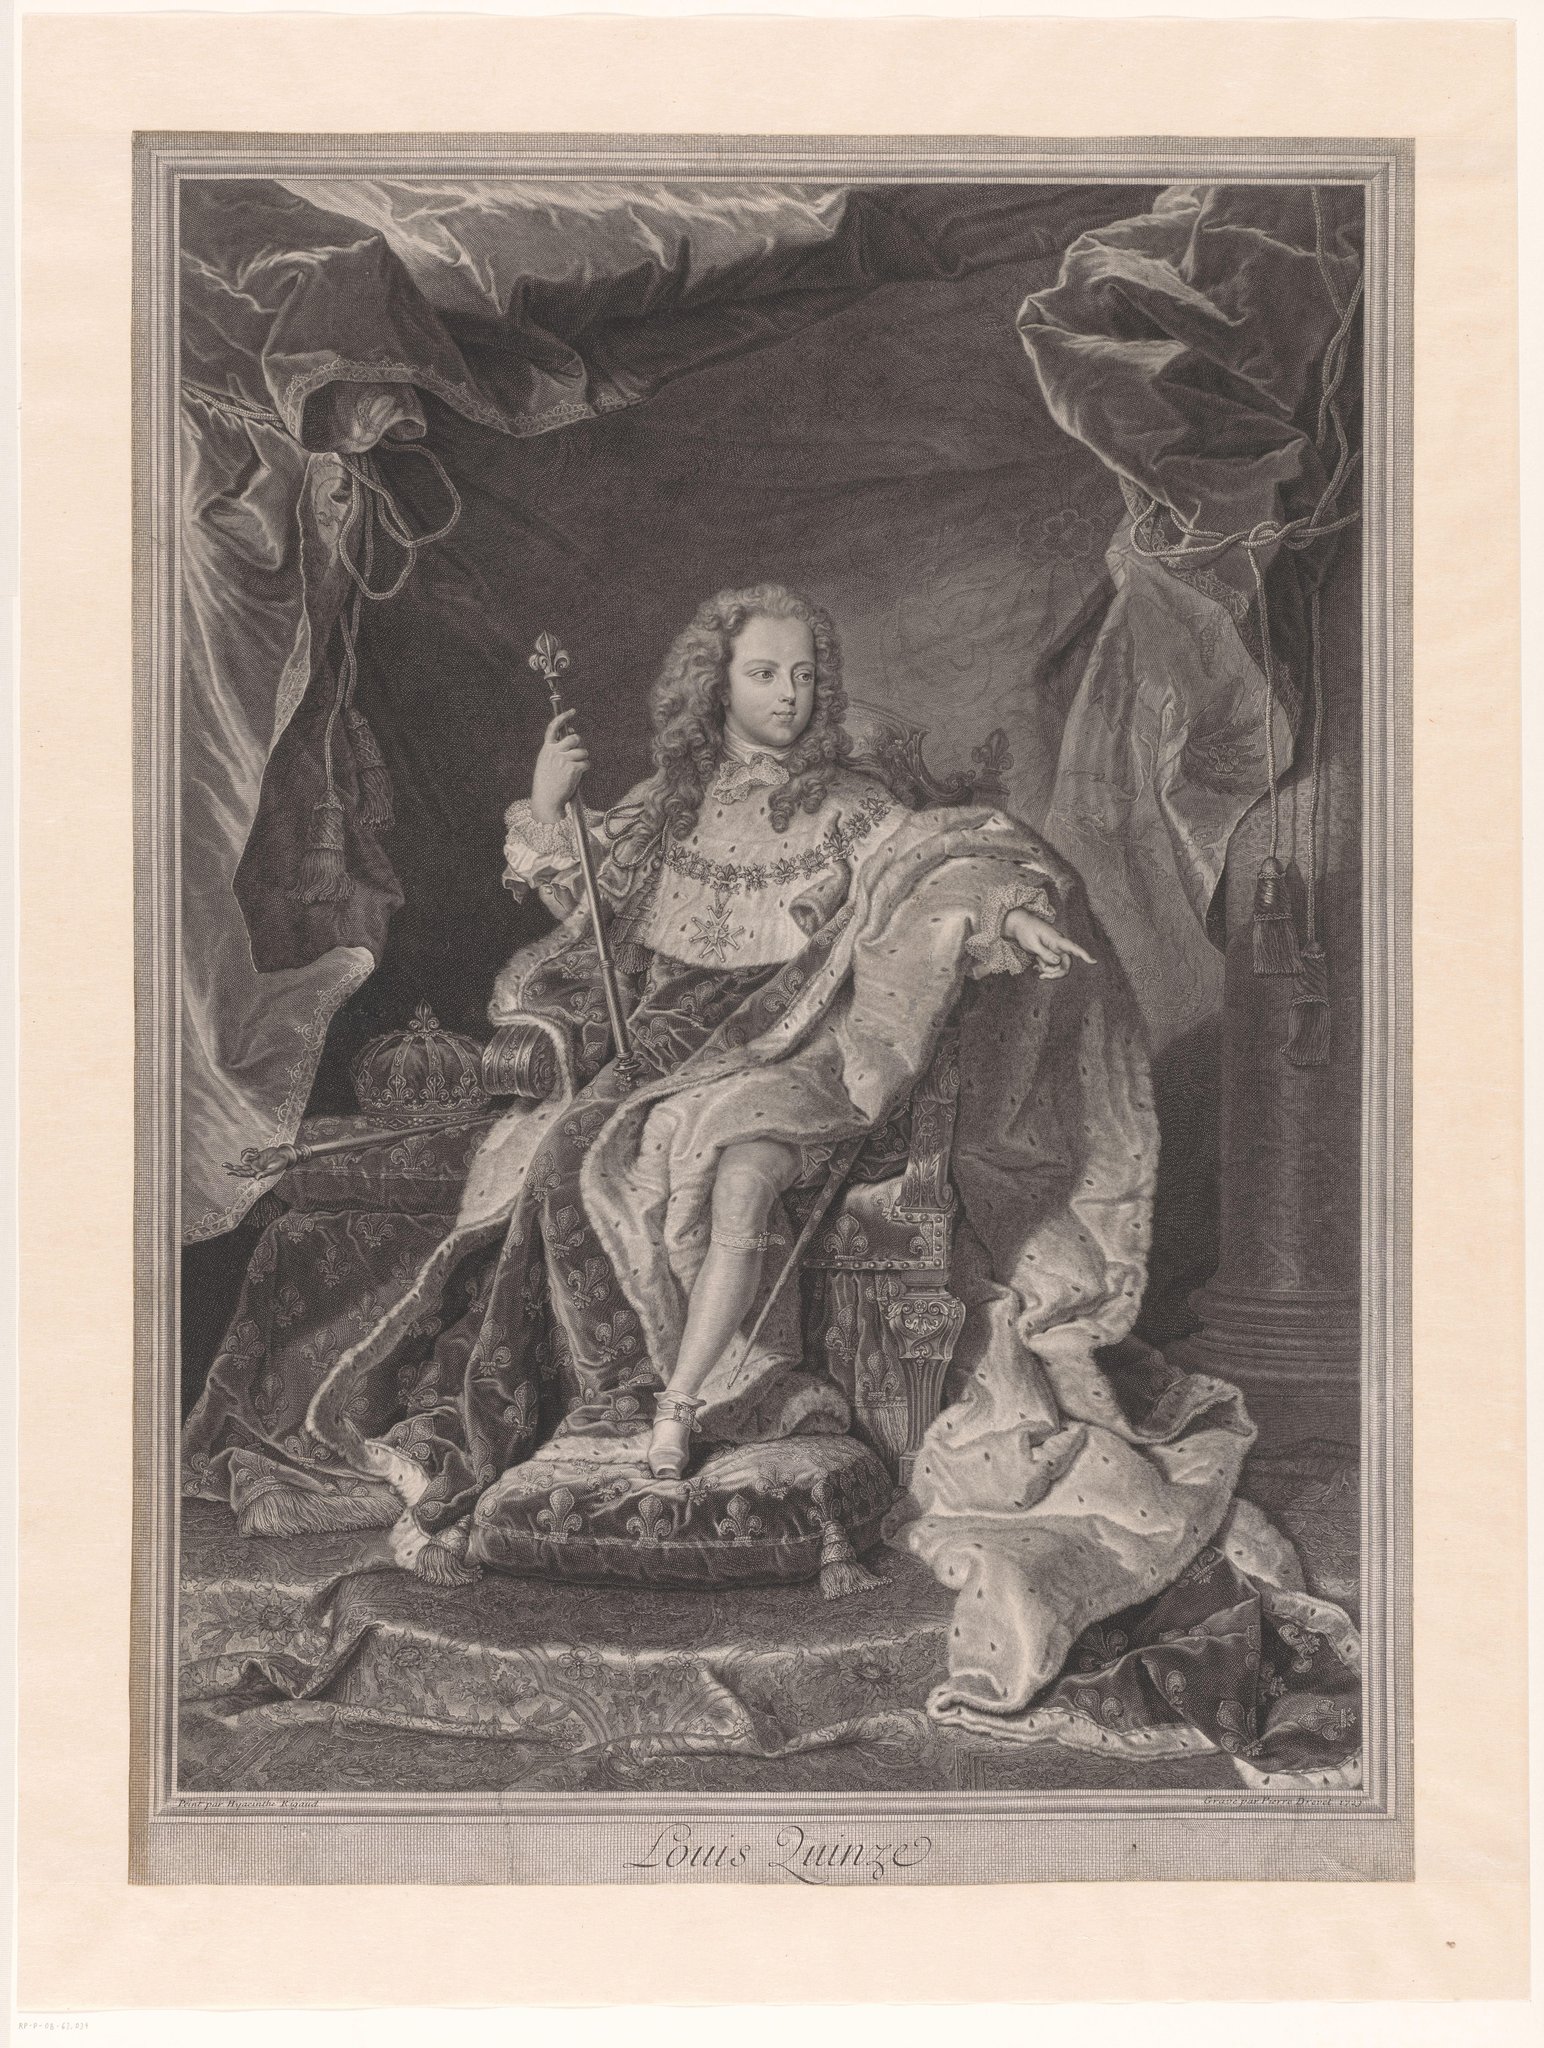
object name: print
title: Portret van Lodewijk XV van Frankrijk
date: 1723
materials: paper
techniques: engraving, etching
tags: louis xv of france, historical persons, king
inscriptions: date